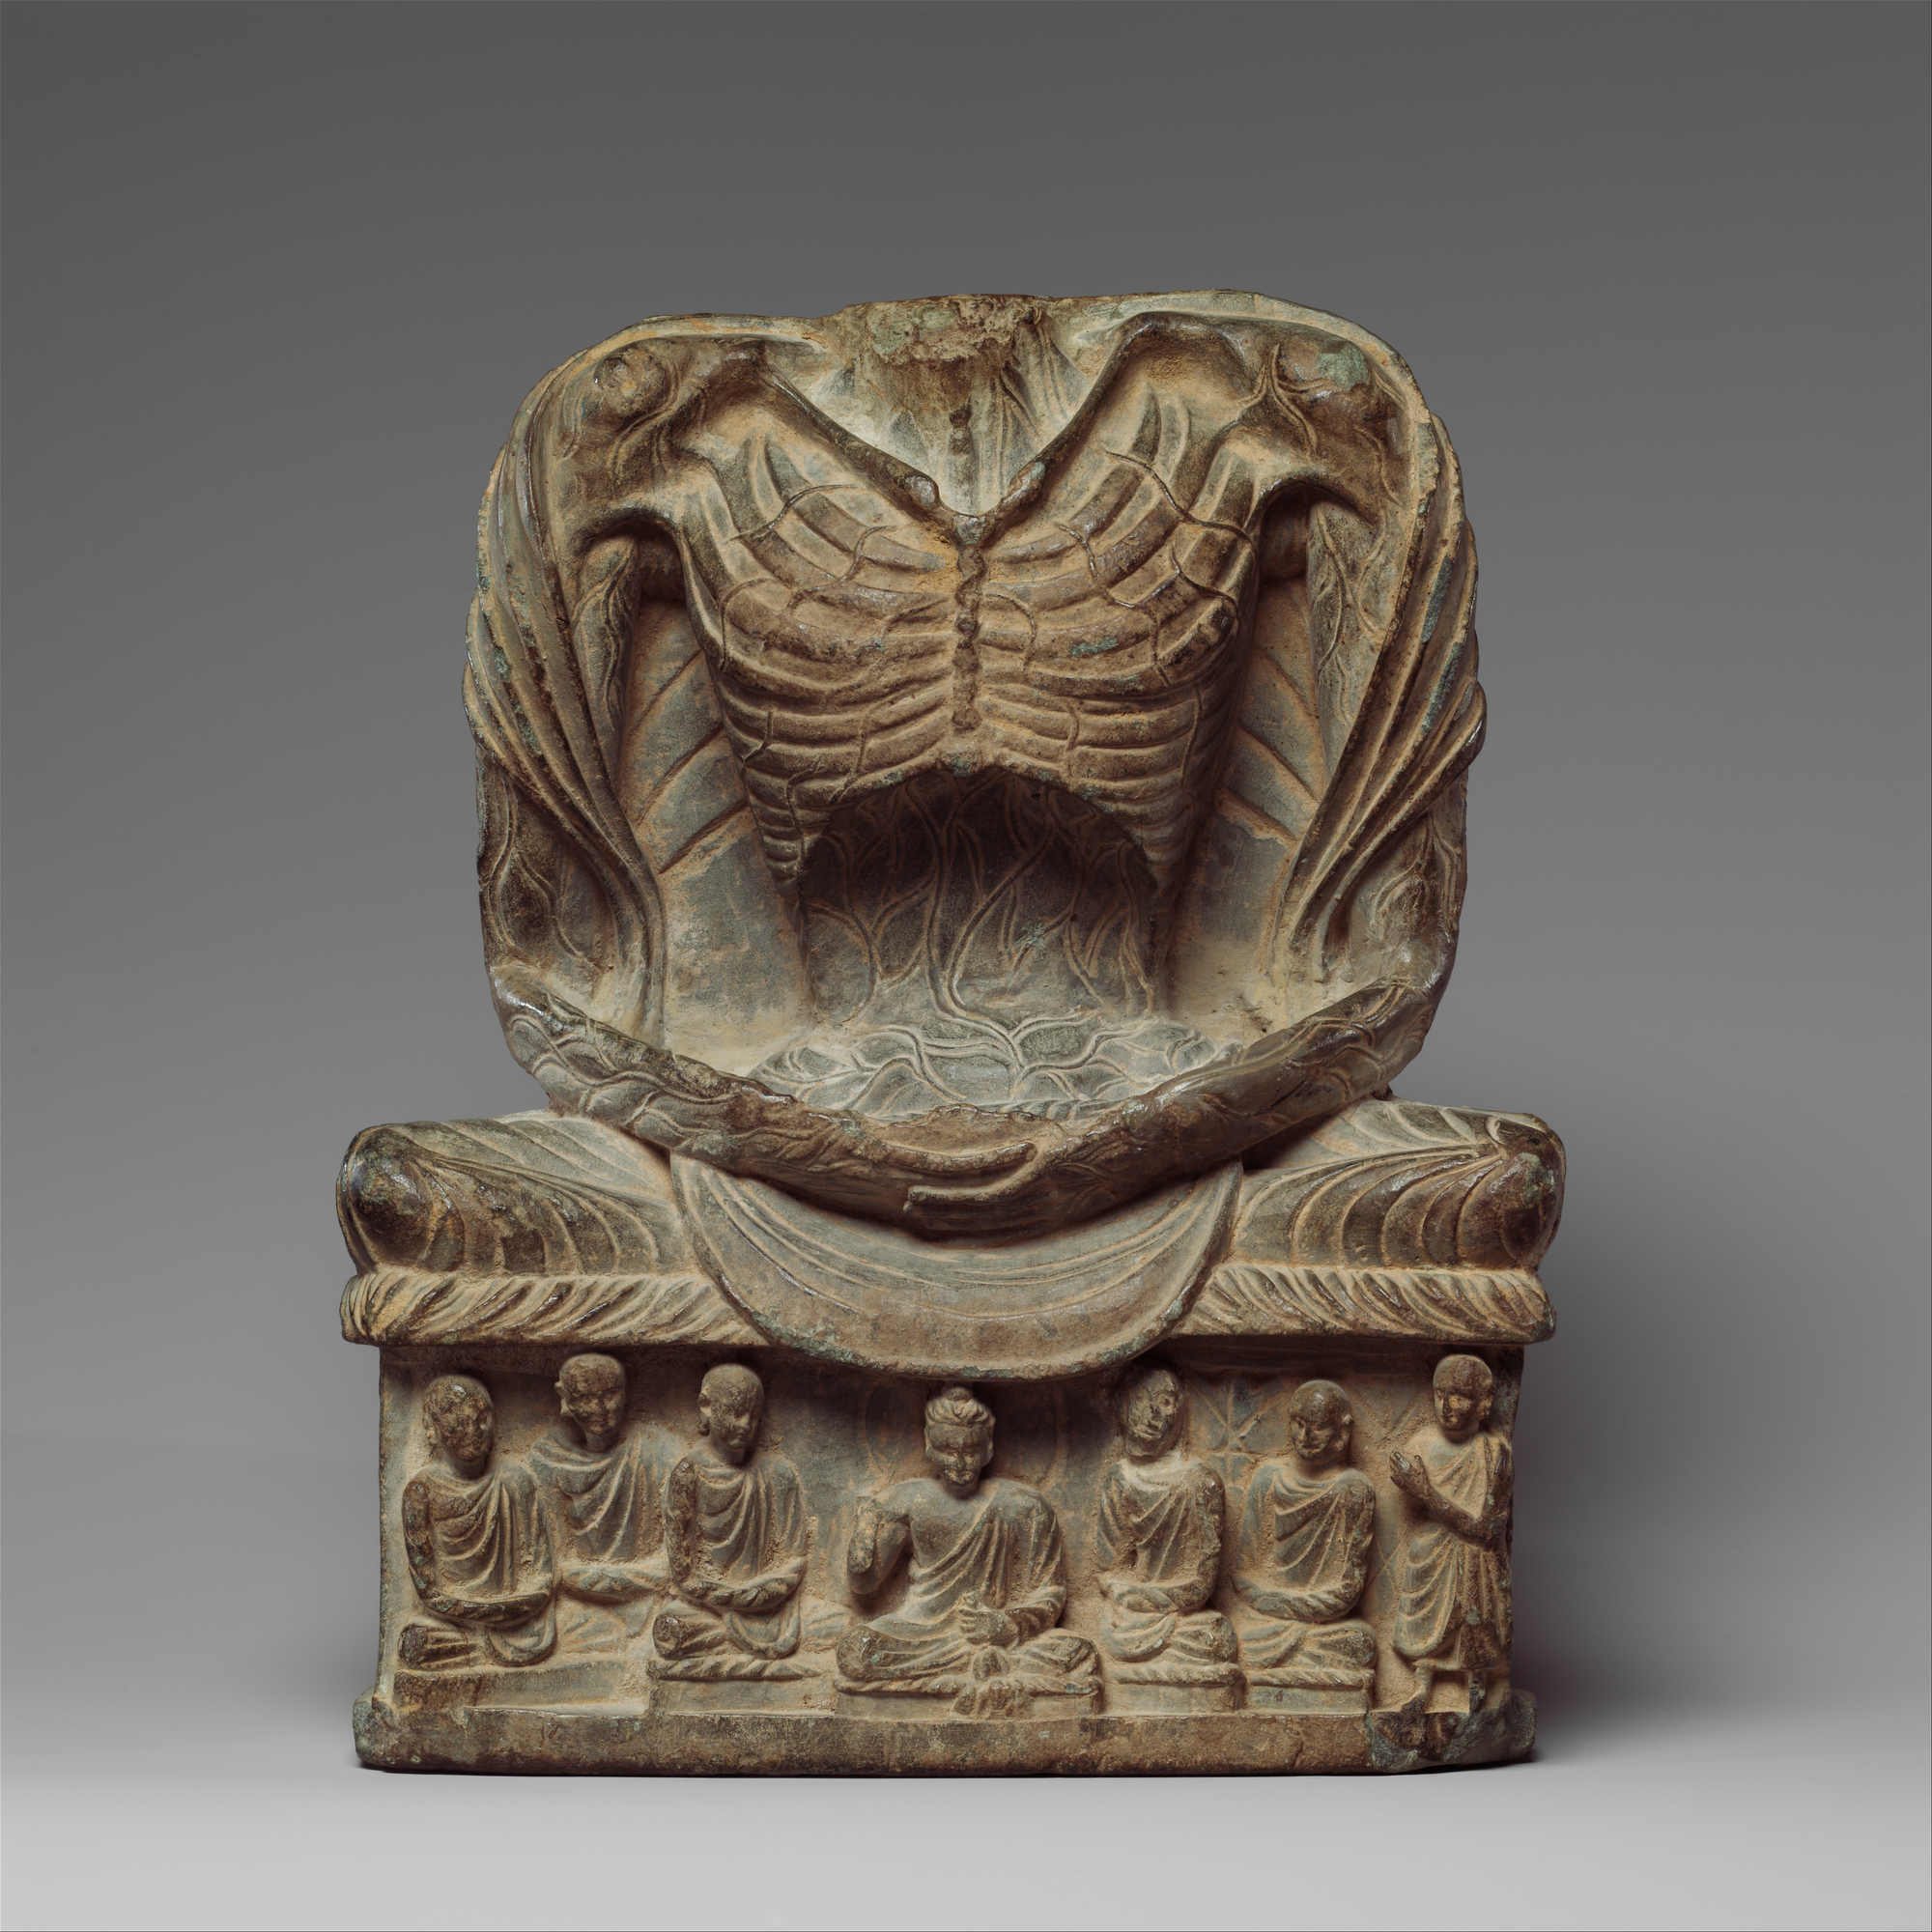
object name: figure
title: Fasting Buddha Shakyamuni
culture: gandhara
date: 201-500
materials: stone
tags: gandhara,buddhism,buddha,shakyamuni